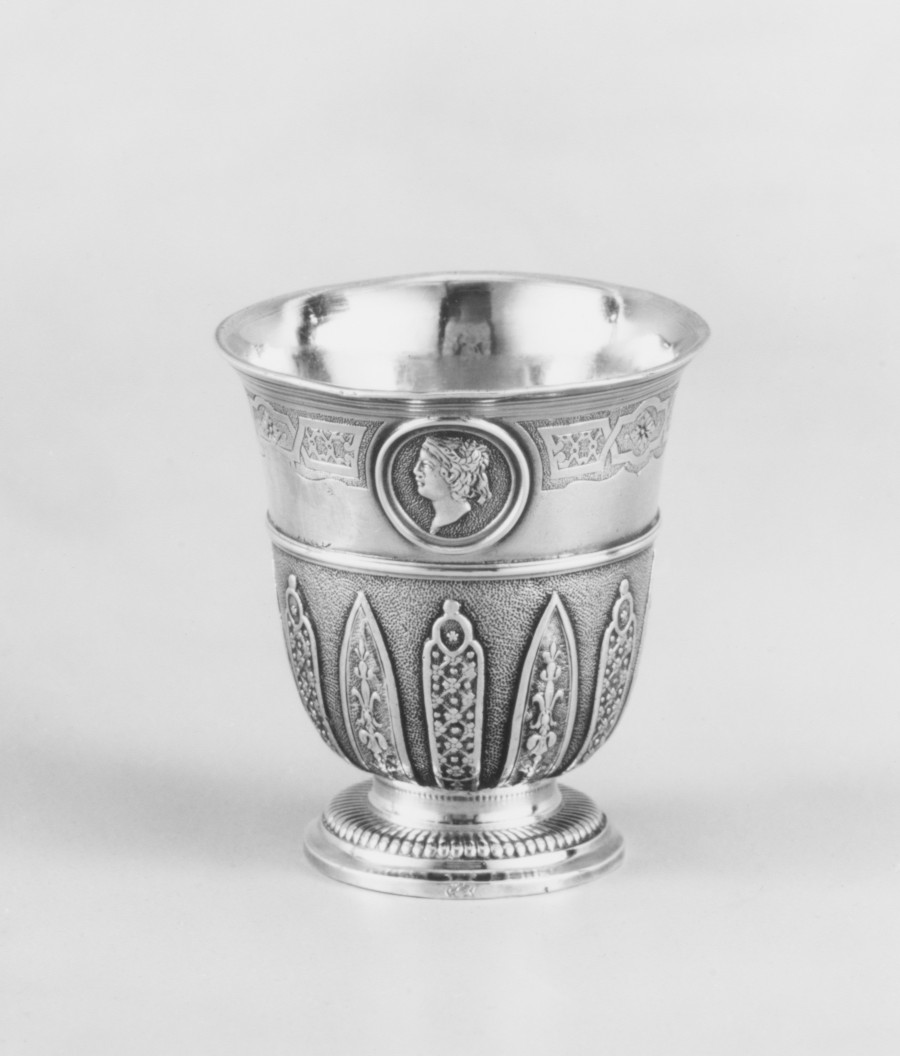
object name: beaker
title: Beaker (one of a pair)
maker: jacques filassier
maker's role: maker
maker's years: 1688-1760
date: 1729-1730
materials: silver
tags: profiles